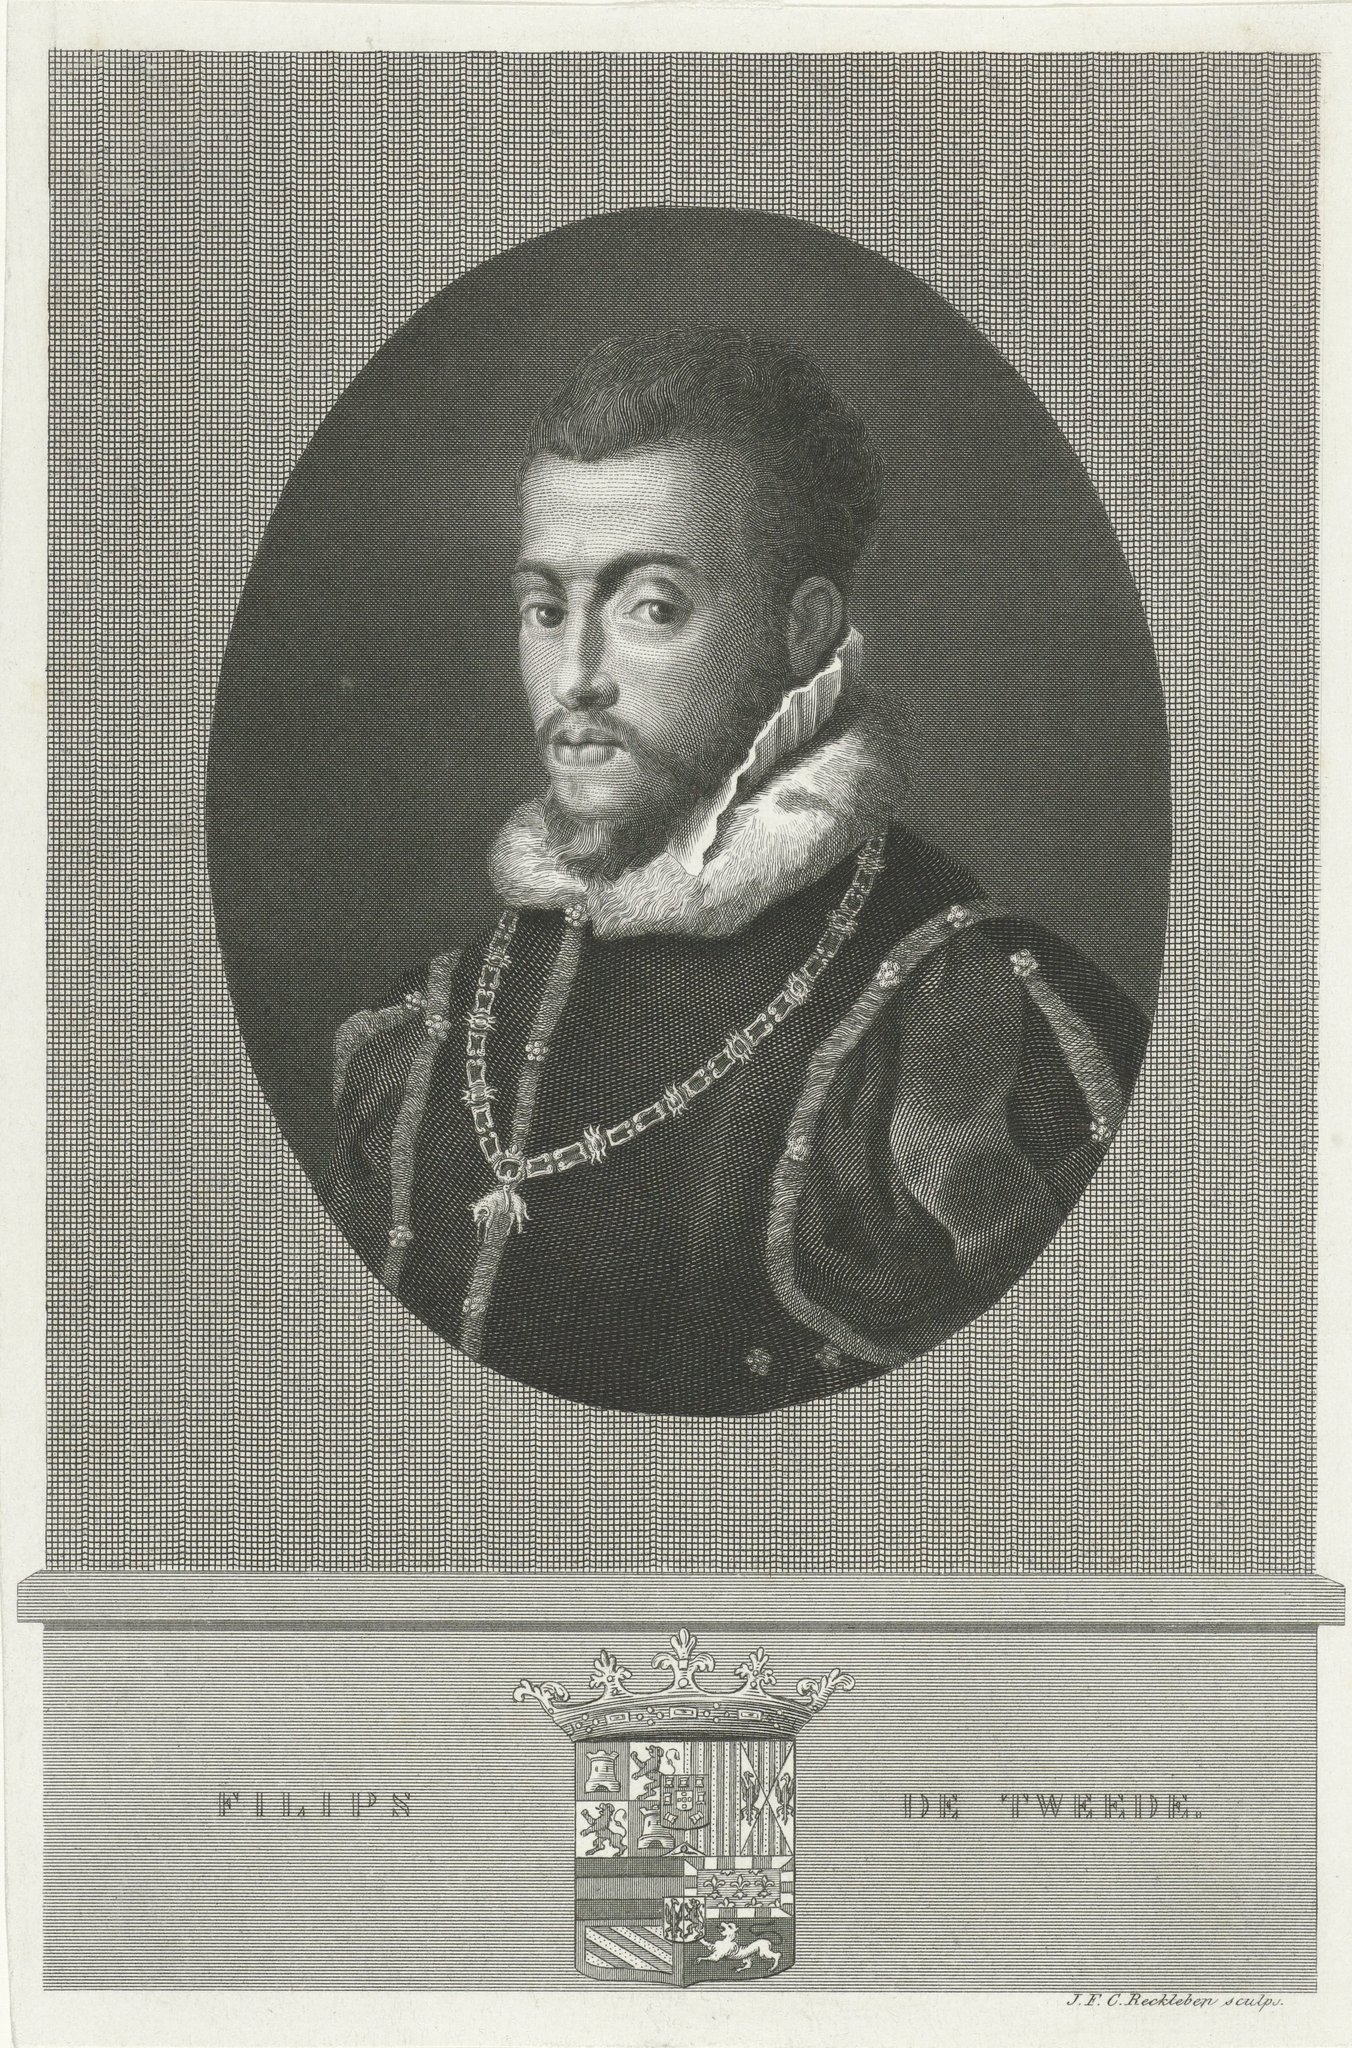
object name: print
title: Portret van Filips II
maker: jan frederik christiaan reckleben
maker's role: print maker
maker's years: 1819-1879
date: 1849-1851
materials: paper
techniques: engraving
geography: amsterdam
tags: philip ii of spain, knighthood order of the golden fleece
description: Illustratie in: Arend, Johannes Pieter. Algemeene geschiedenis des vaderlands van de vroegste tijden tot op heden. 5 delen, Amsterdam: Schleijer, J.F. 1840-1884, dl. 2.4, p. 52.